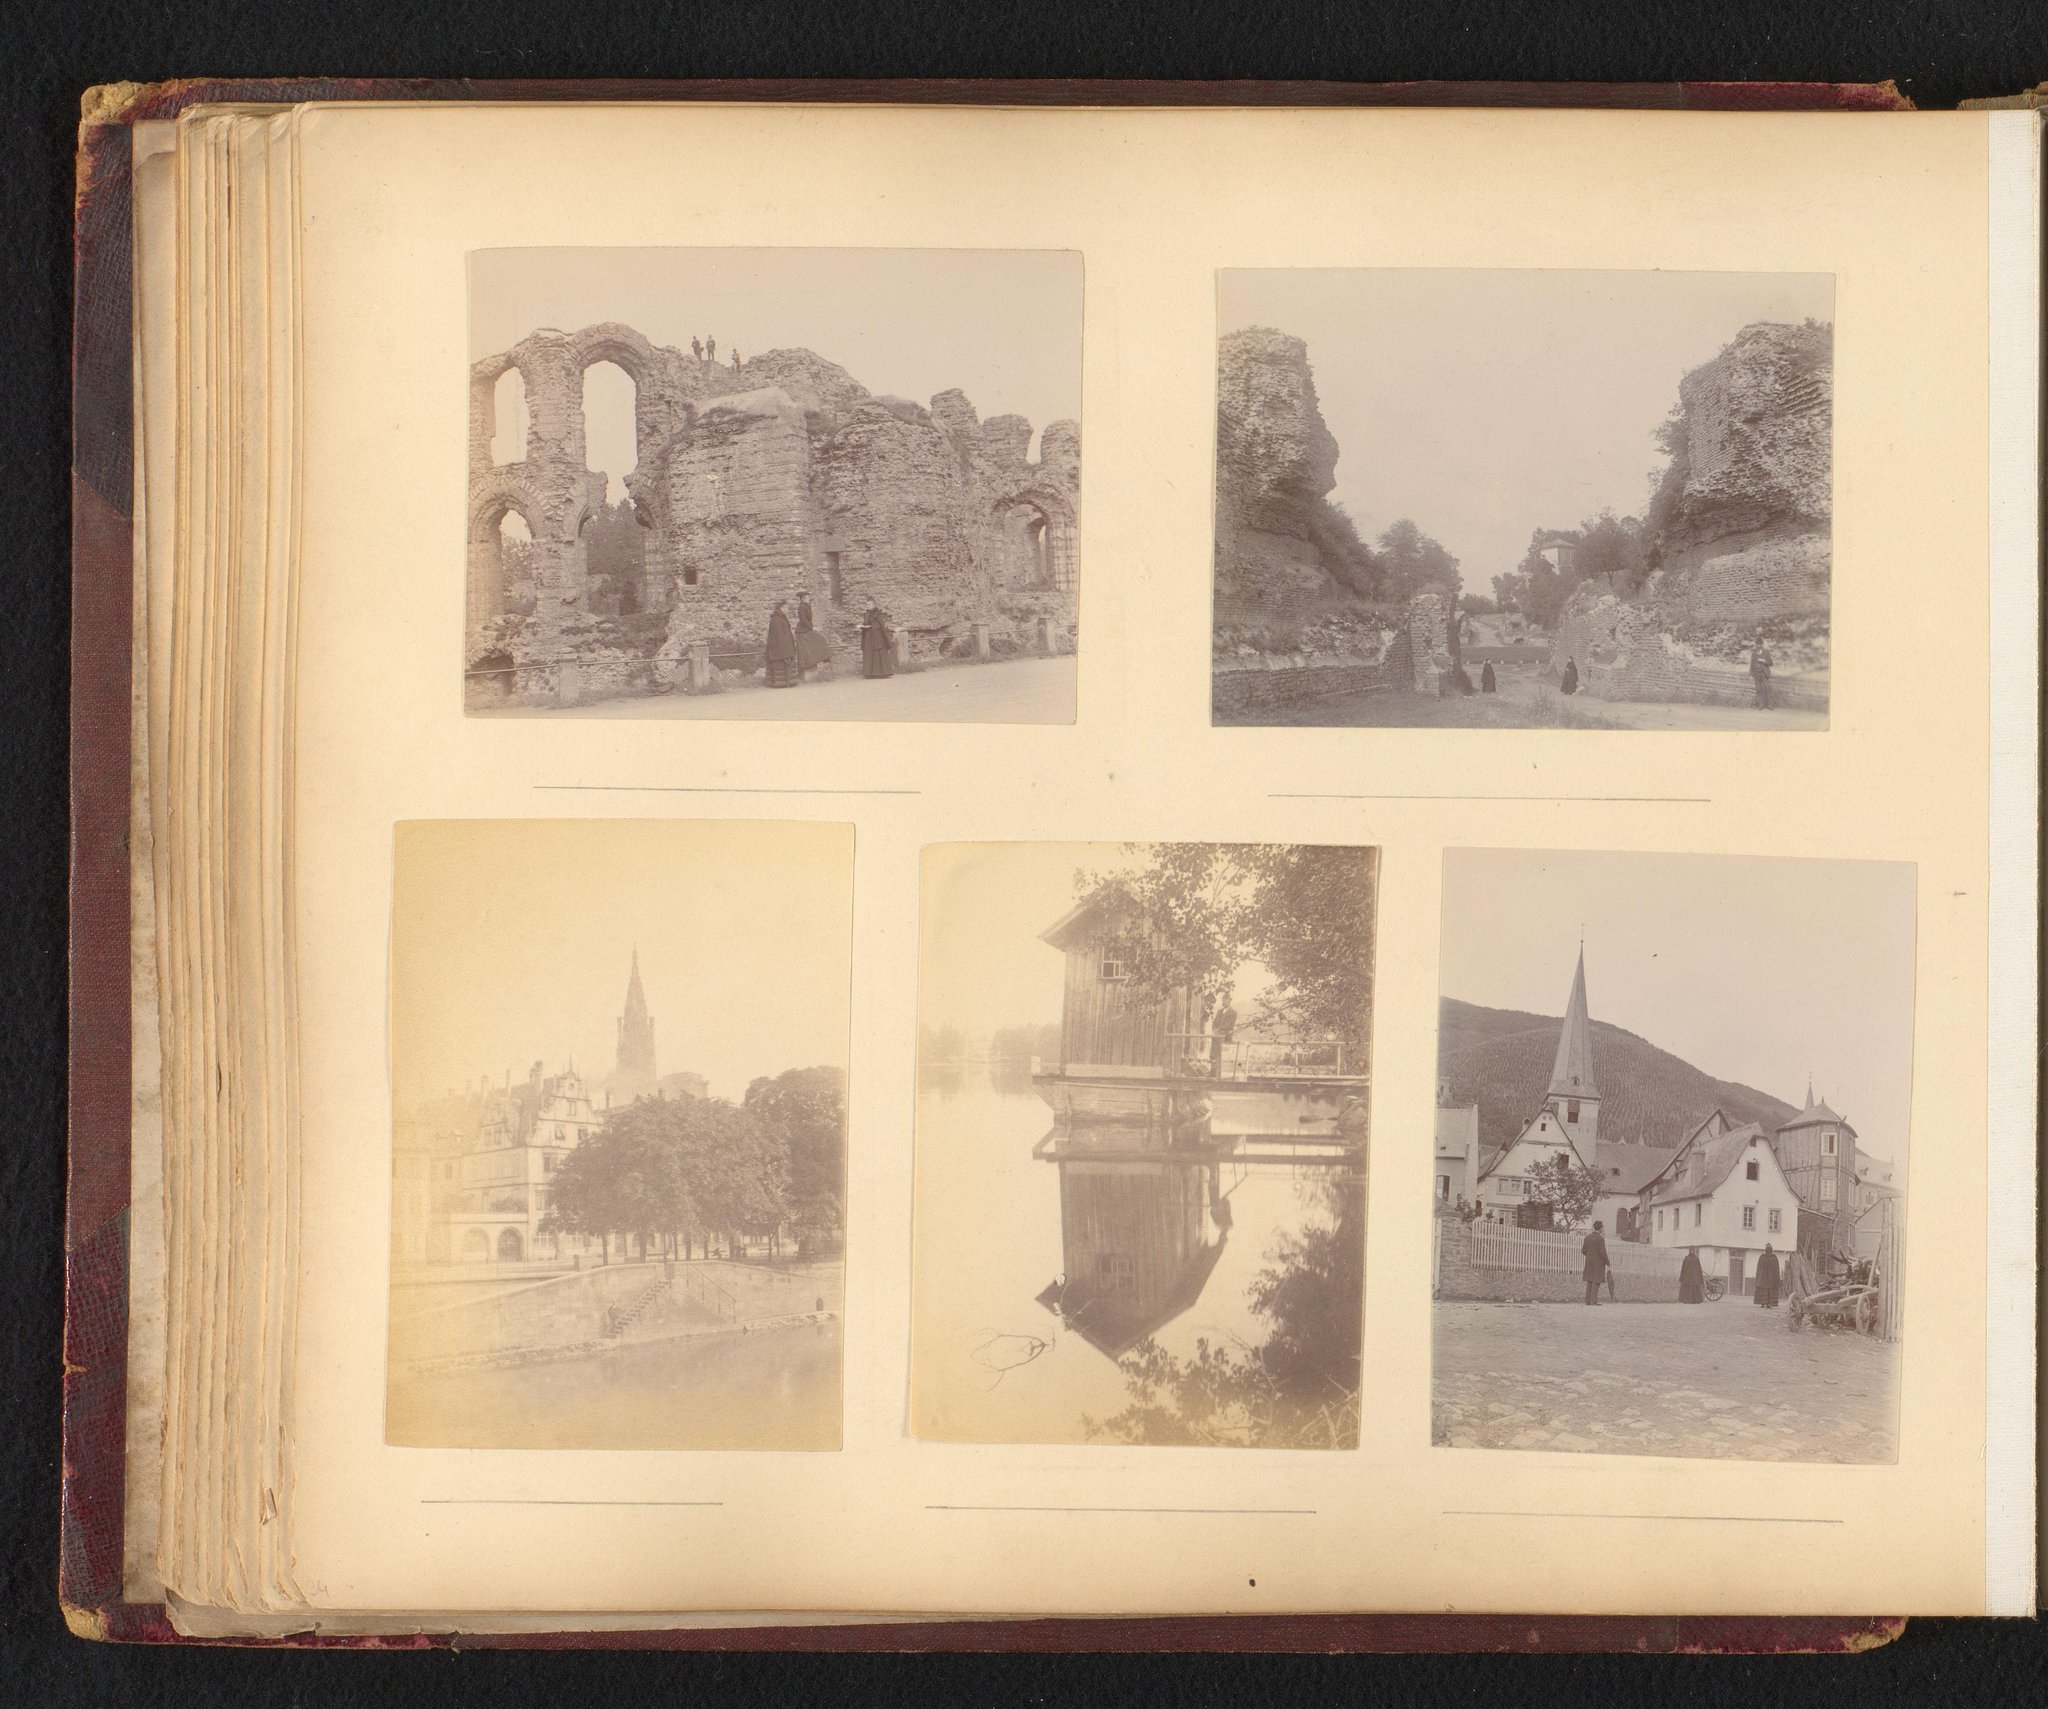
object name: photograph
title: Diverse onderwerpen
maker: Anonymous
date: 1890-1898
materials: photographic support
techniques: albumen print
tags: city-view in general; 'veduta', ruin of a building ~ architecture, landscapes with waters, waterscapes, seascapes (in the temperate zone)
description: Personen bij ruïnes, een man bij een huisje en stads- of dorpsgezichten. Deze pagina maakt deel uit van een album.